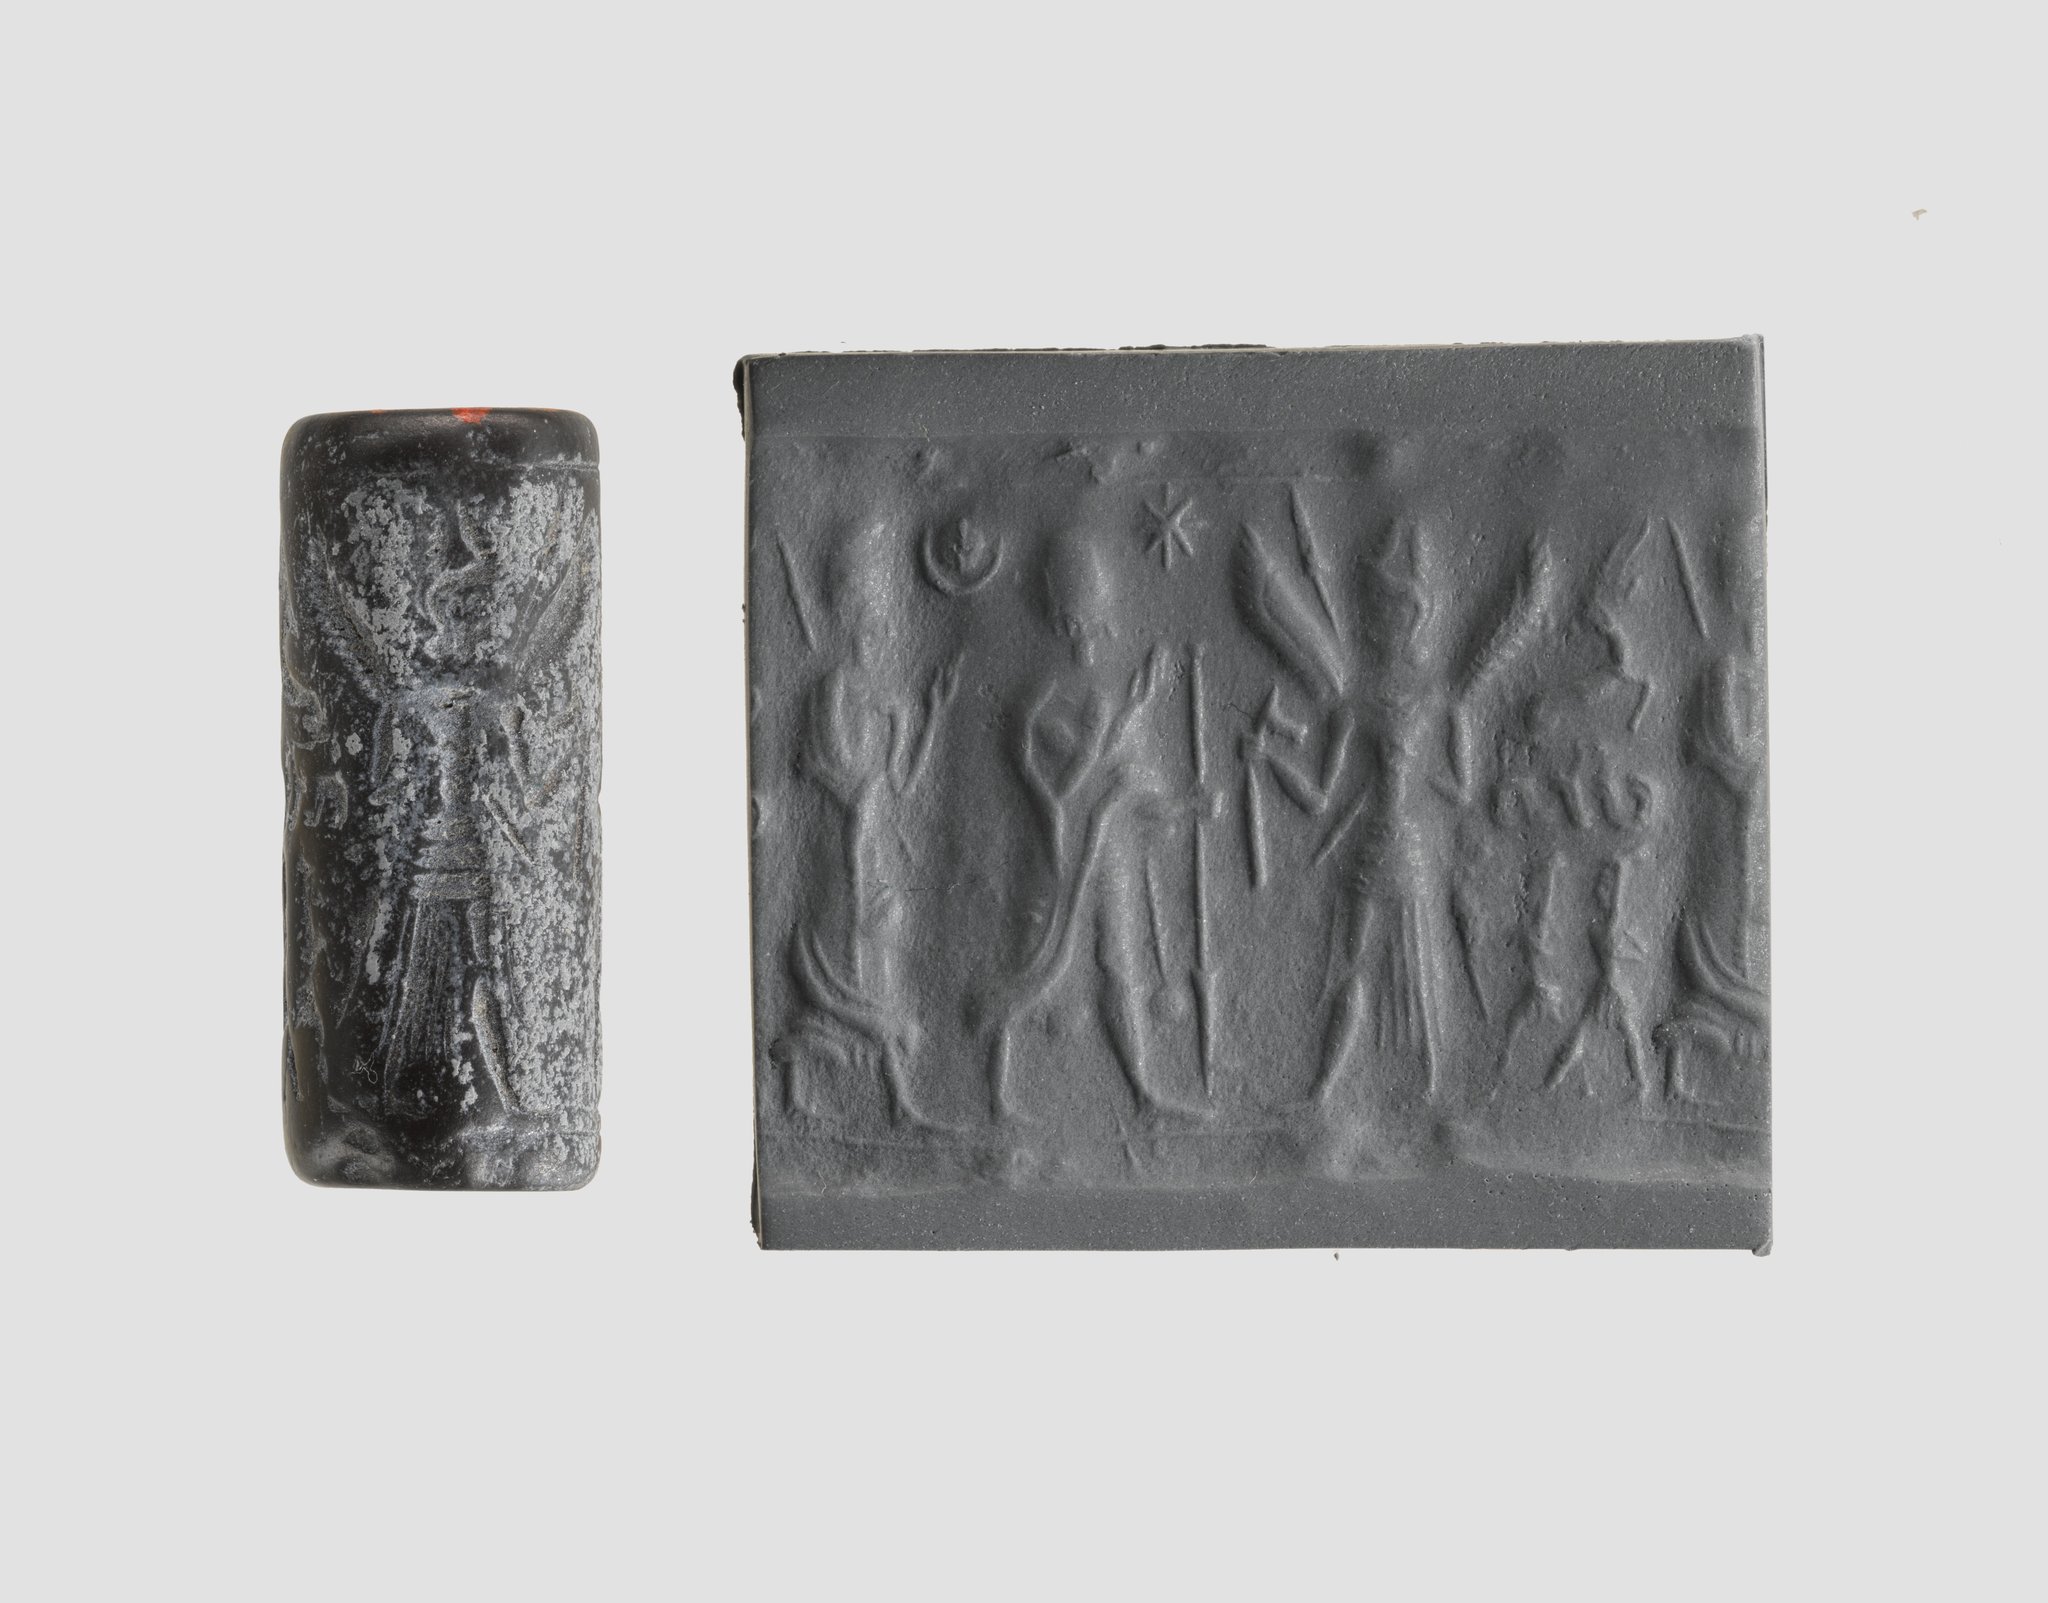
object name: cylinder seal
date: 1720-1650 BCE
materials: stone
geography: syria